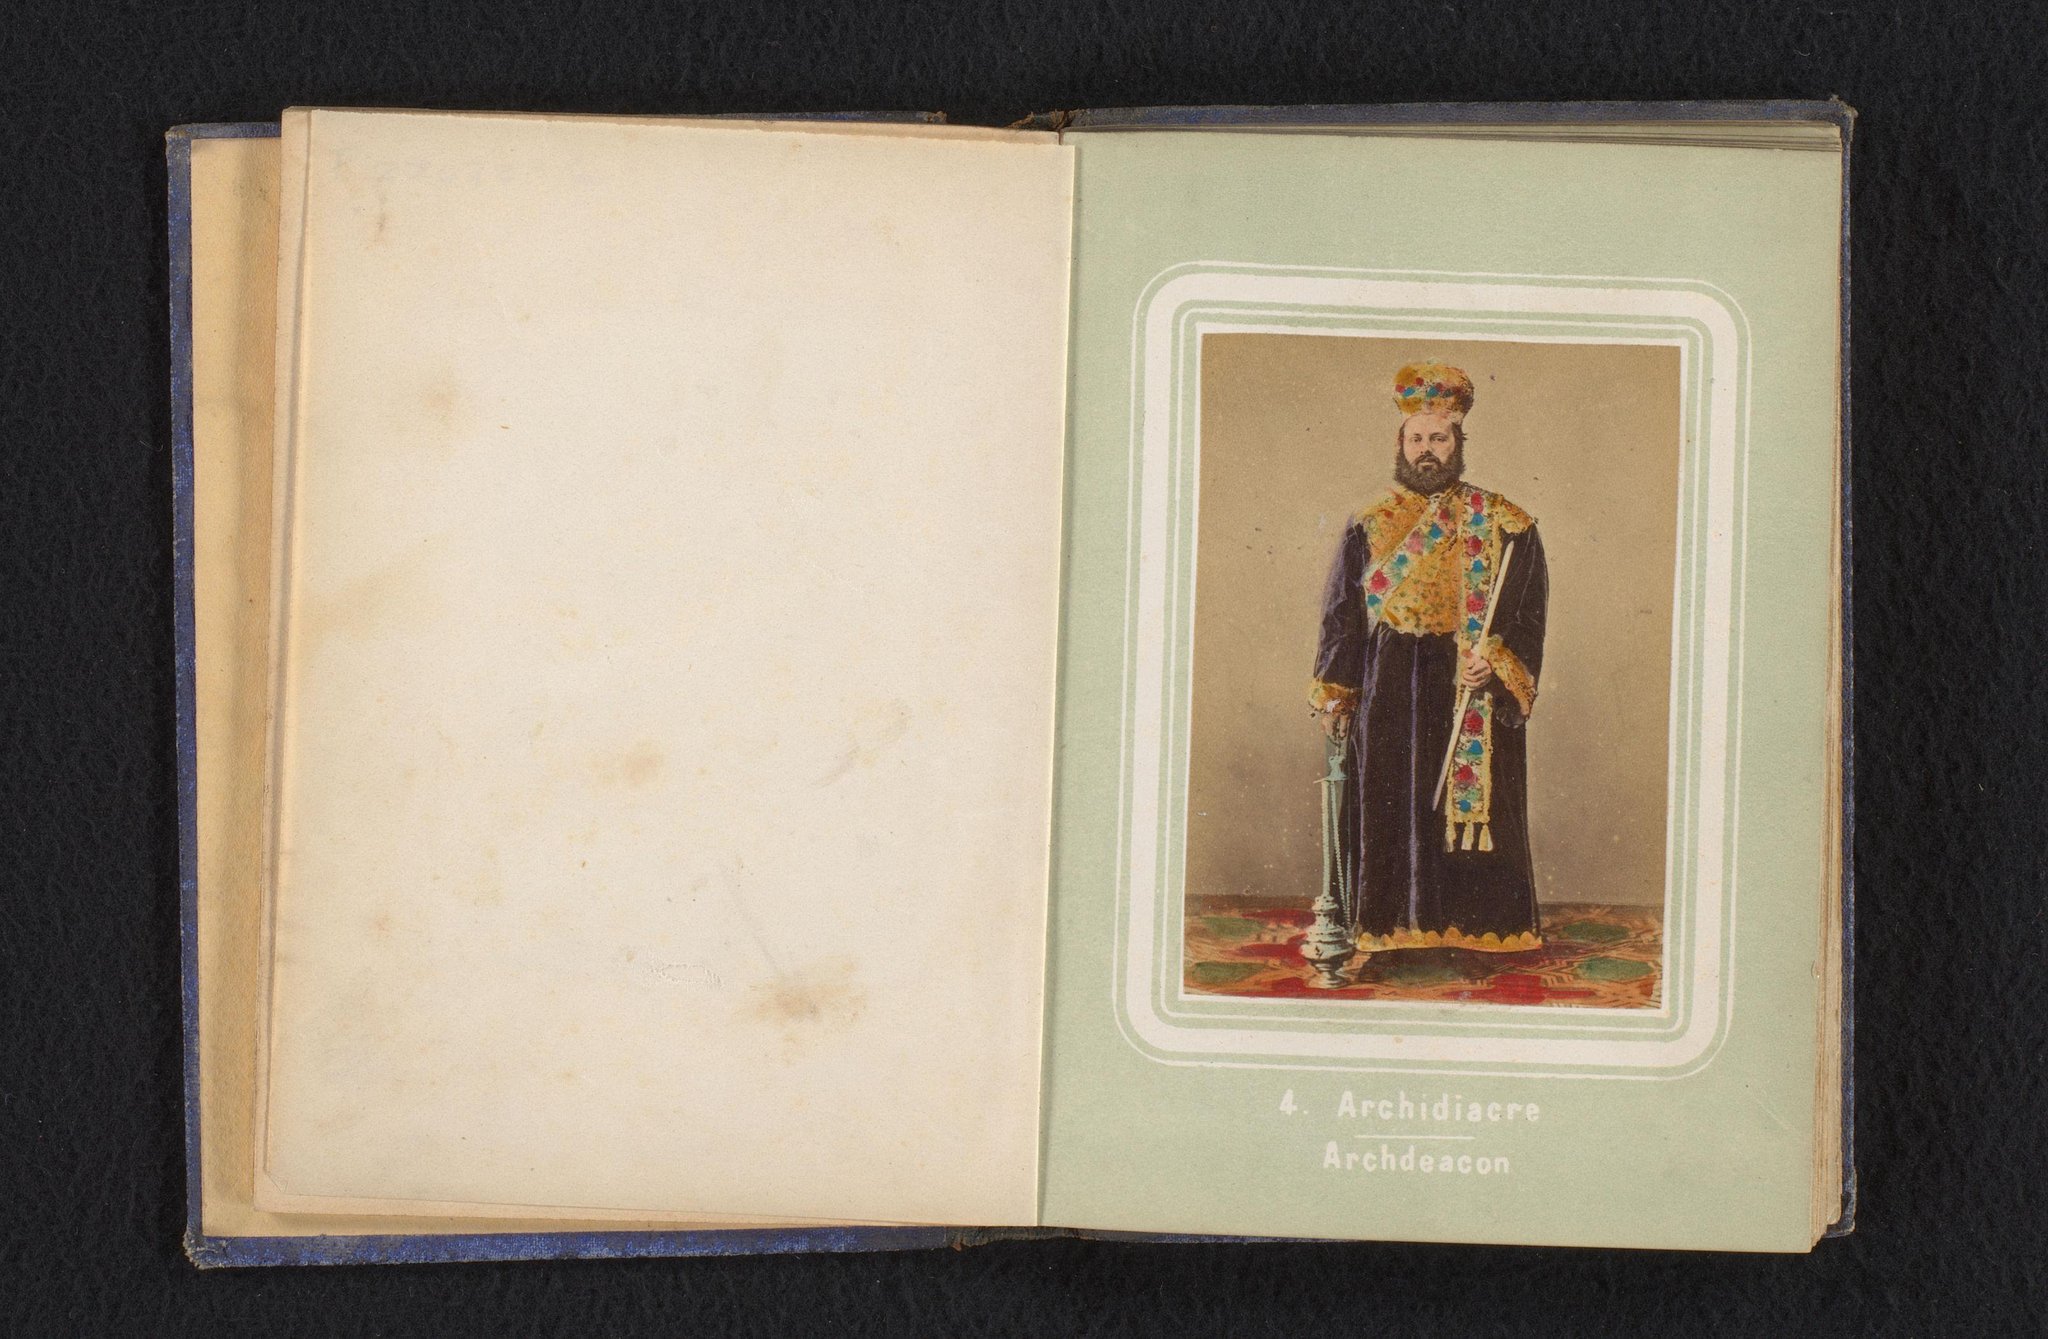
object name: photograph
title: Archidiacre / Archdeacon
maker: Anonymous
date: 1870-1890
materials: paper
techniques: albumen print, hand coloring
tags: deacon (roman catholic), anonymous historical person portrayed